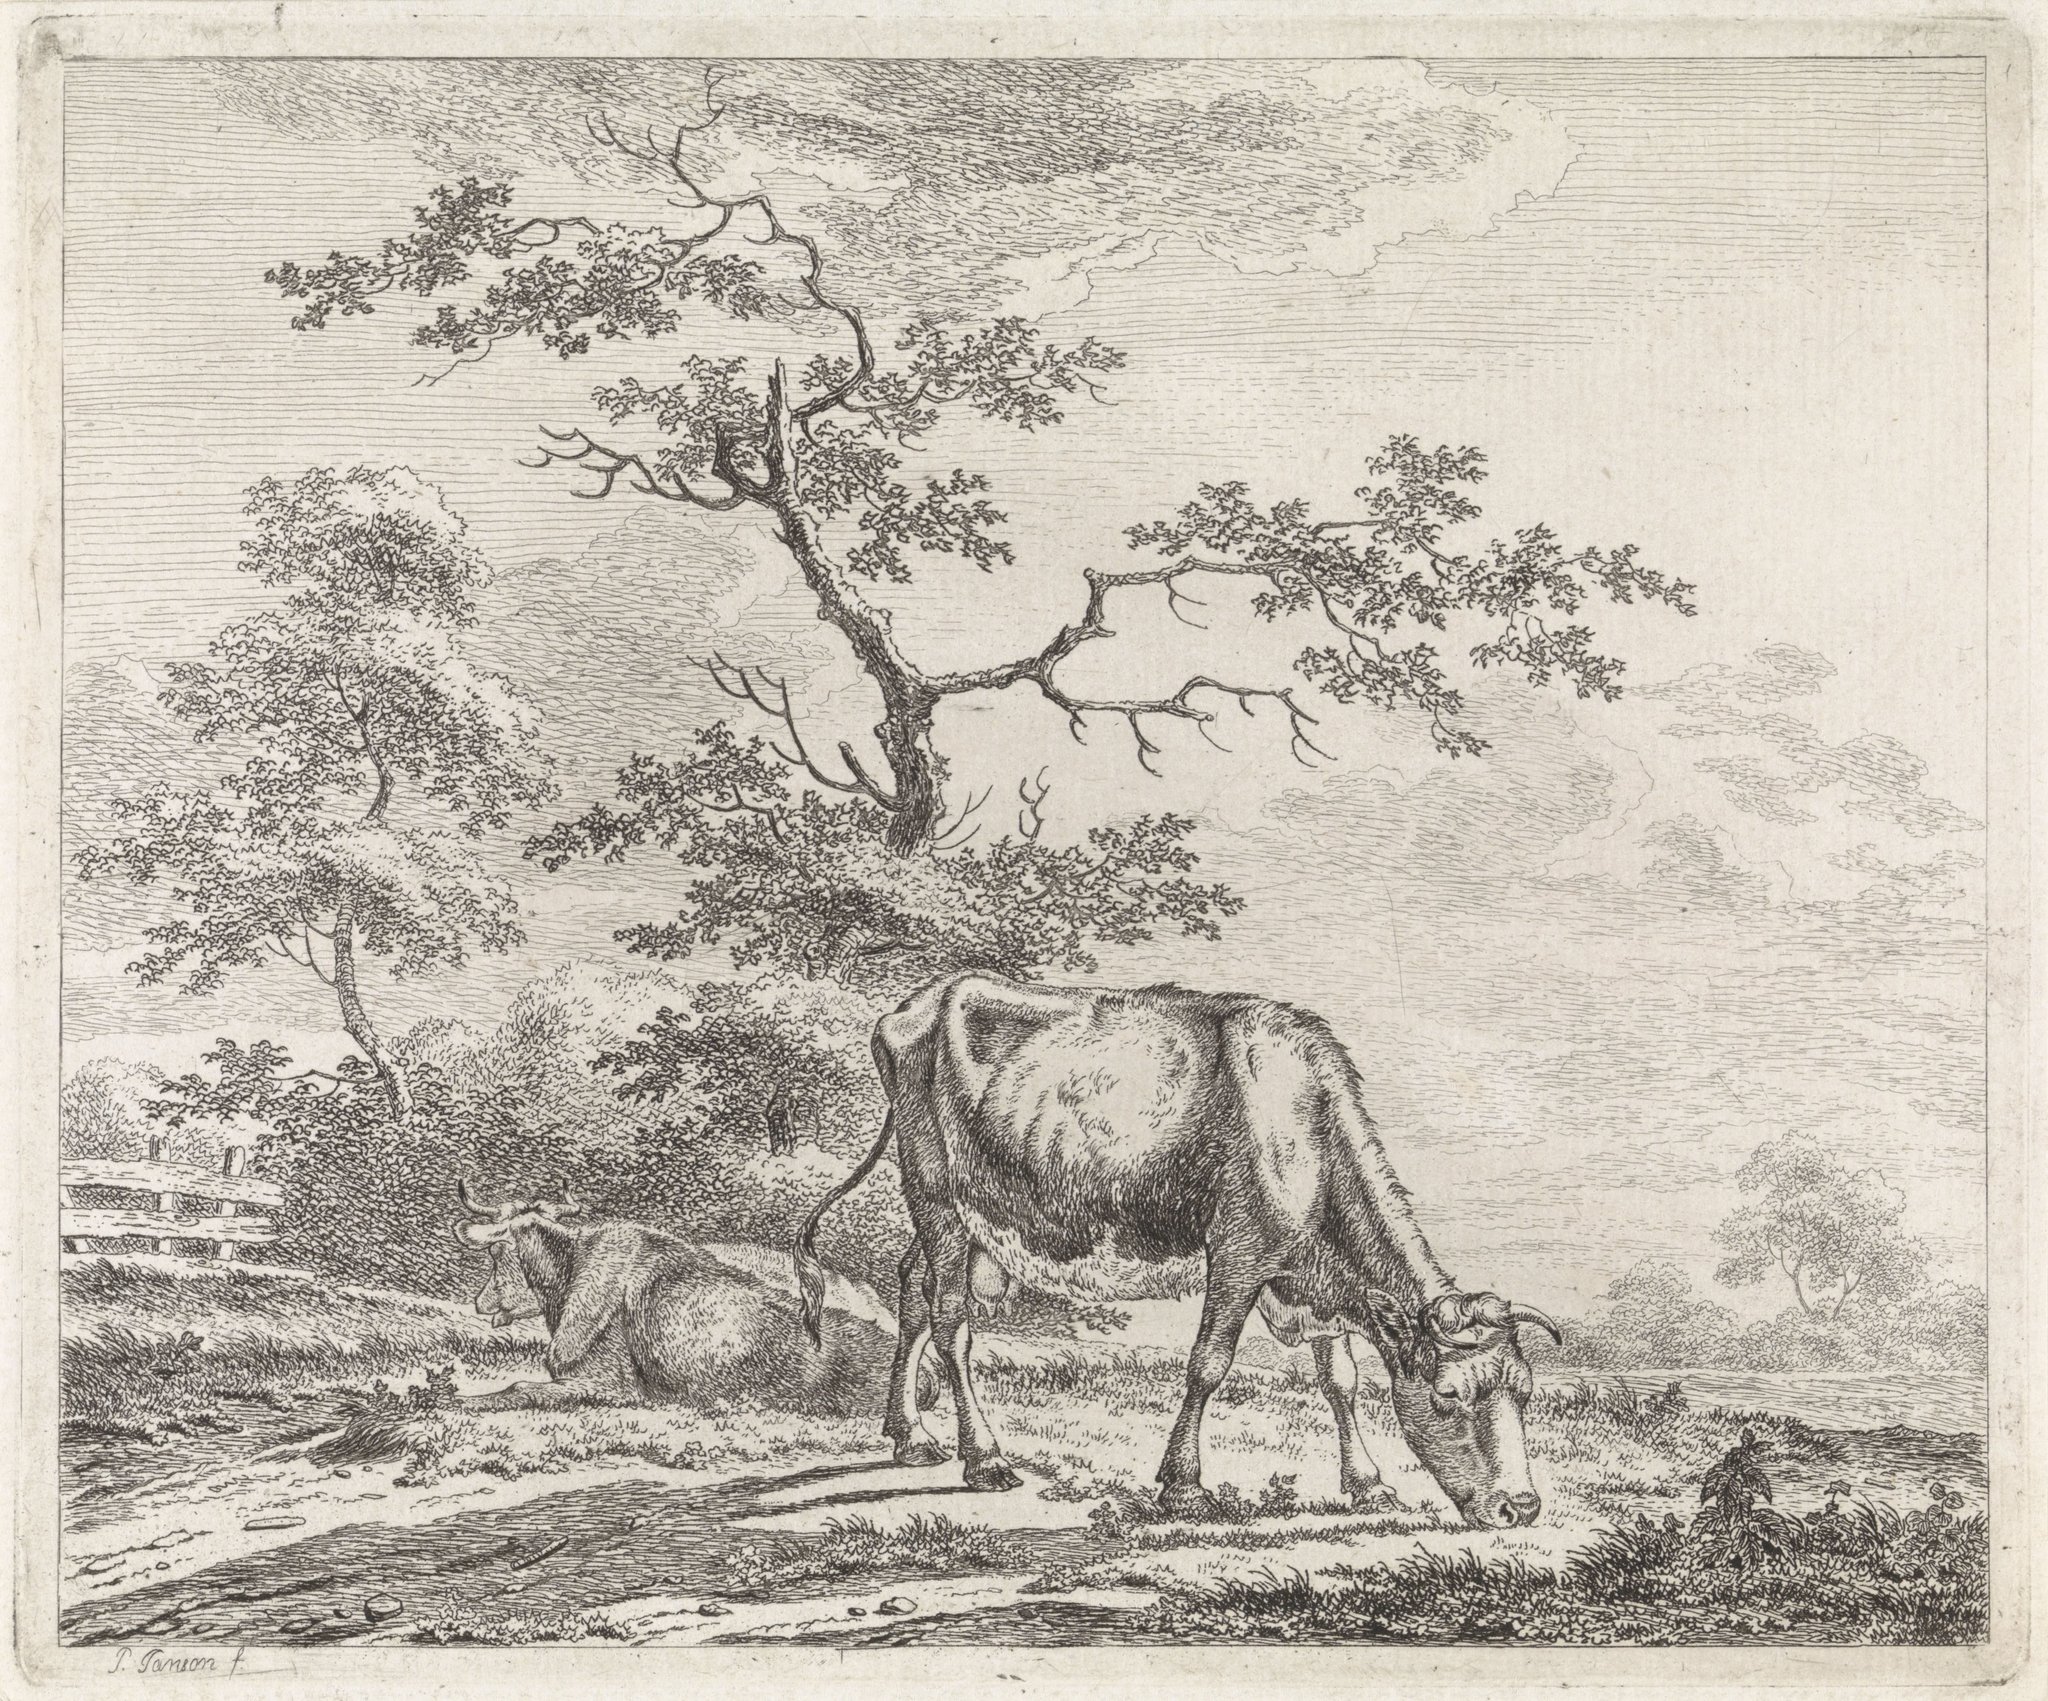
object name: print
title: Landschap met grazende koe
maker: pieter janson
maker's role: draughtsman, print maker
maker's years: 1765-1851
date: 1780-1851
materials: paper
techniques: etching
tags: cow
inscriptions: collector's mark: Lugt 2228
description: Landschap met op de voorgrond een grazende koe. Links een liggende koe, van achter gezien. Mét de lucht.